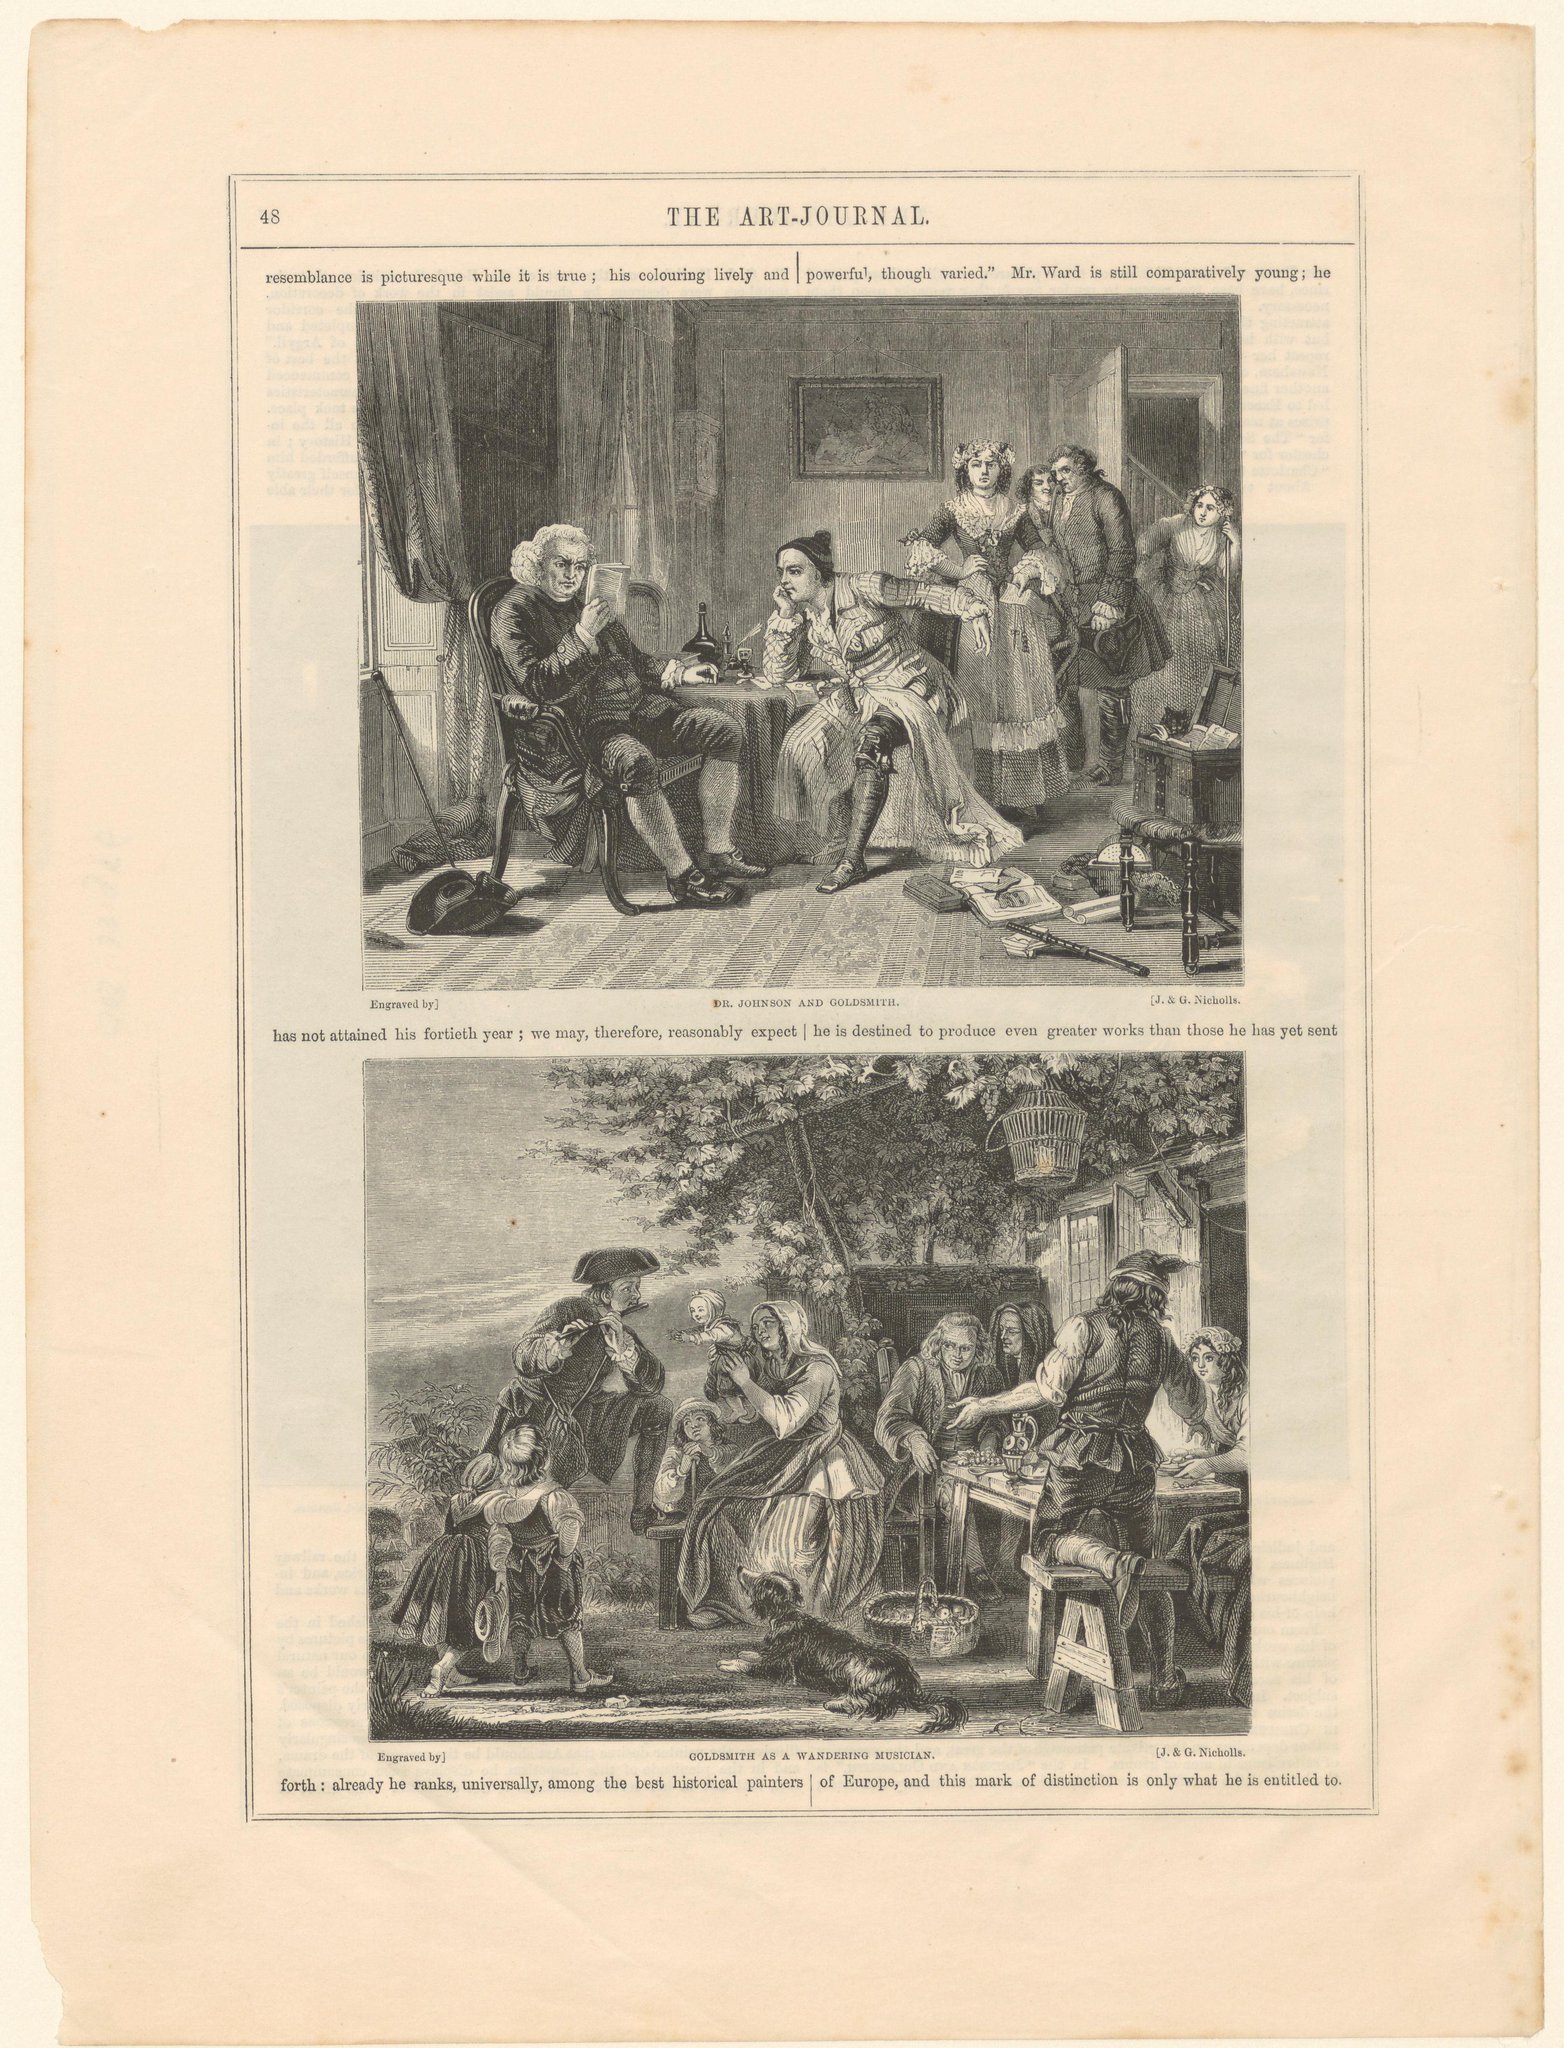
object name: print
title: The sleep of Argyll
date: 1855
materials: paper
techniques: letterpress printing, engraving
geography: london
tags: earl, prison, jail, sleeping in bed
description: Voorstellingen uit het werk 'Johnson and Goldsmith'.